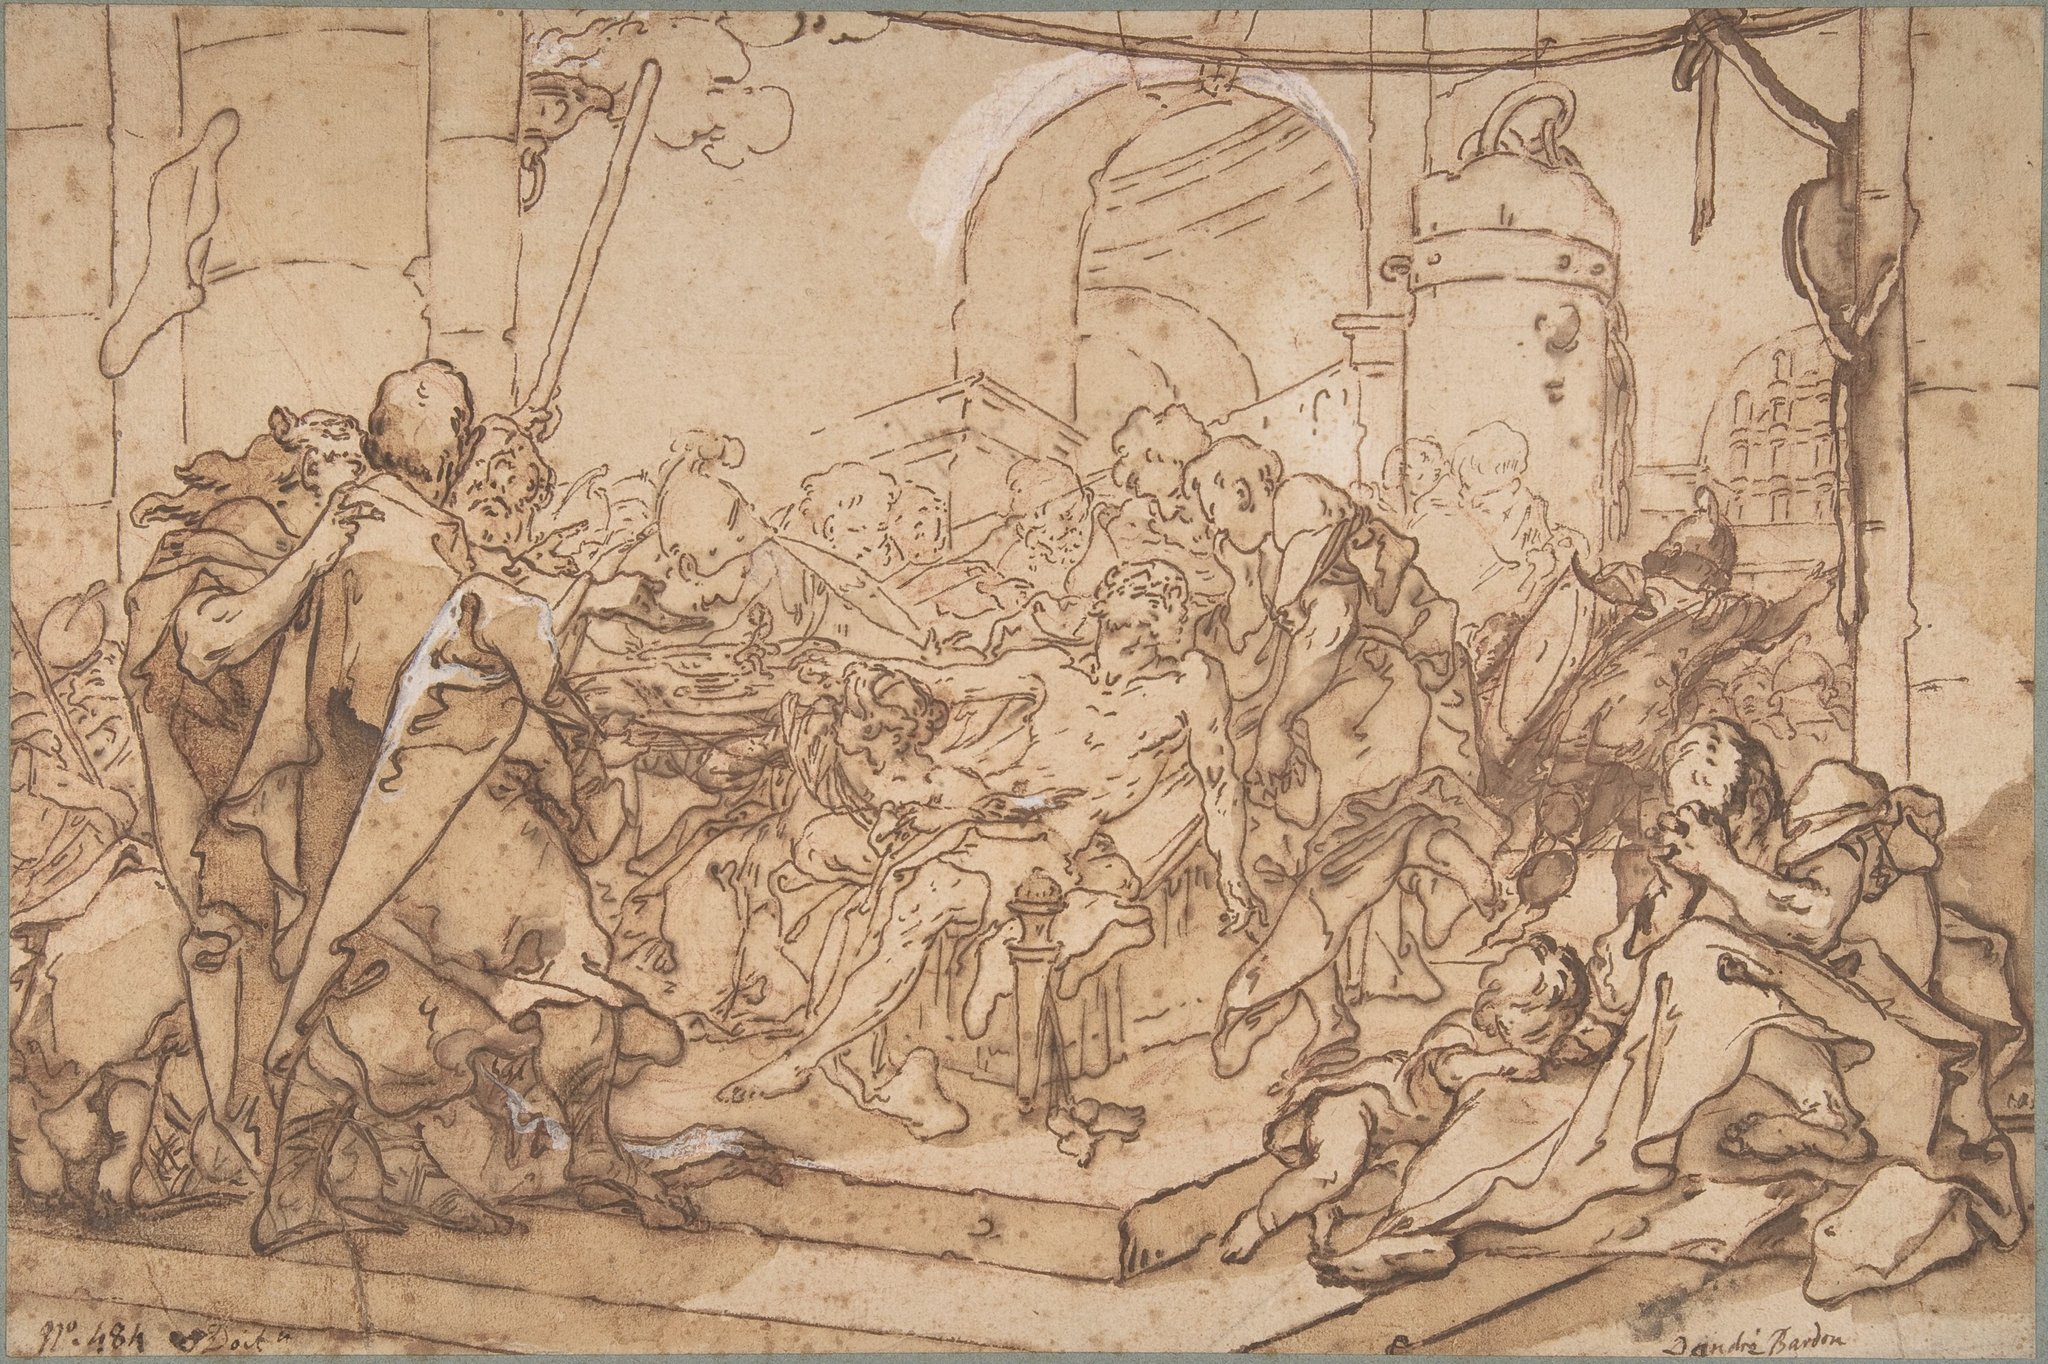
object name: drawing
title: The Death of Socrates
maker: michel françois dandré-bardon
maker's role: artist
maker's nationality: french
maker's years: 1700-1783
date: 1749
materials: chalk, gouache, ink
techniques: brush, heightening, pen, wash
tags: socrates,crowd,death